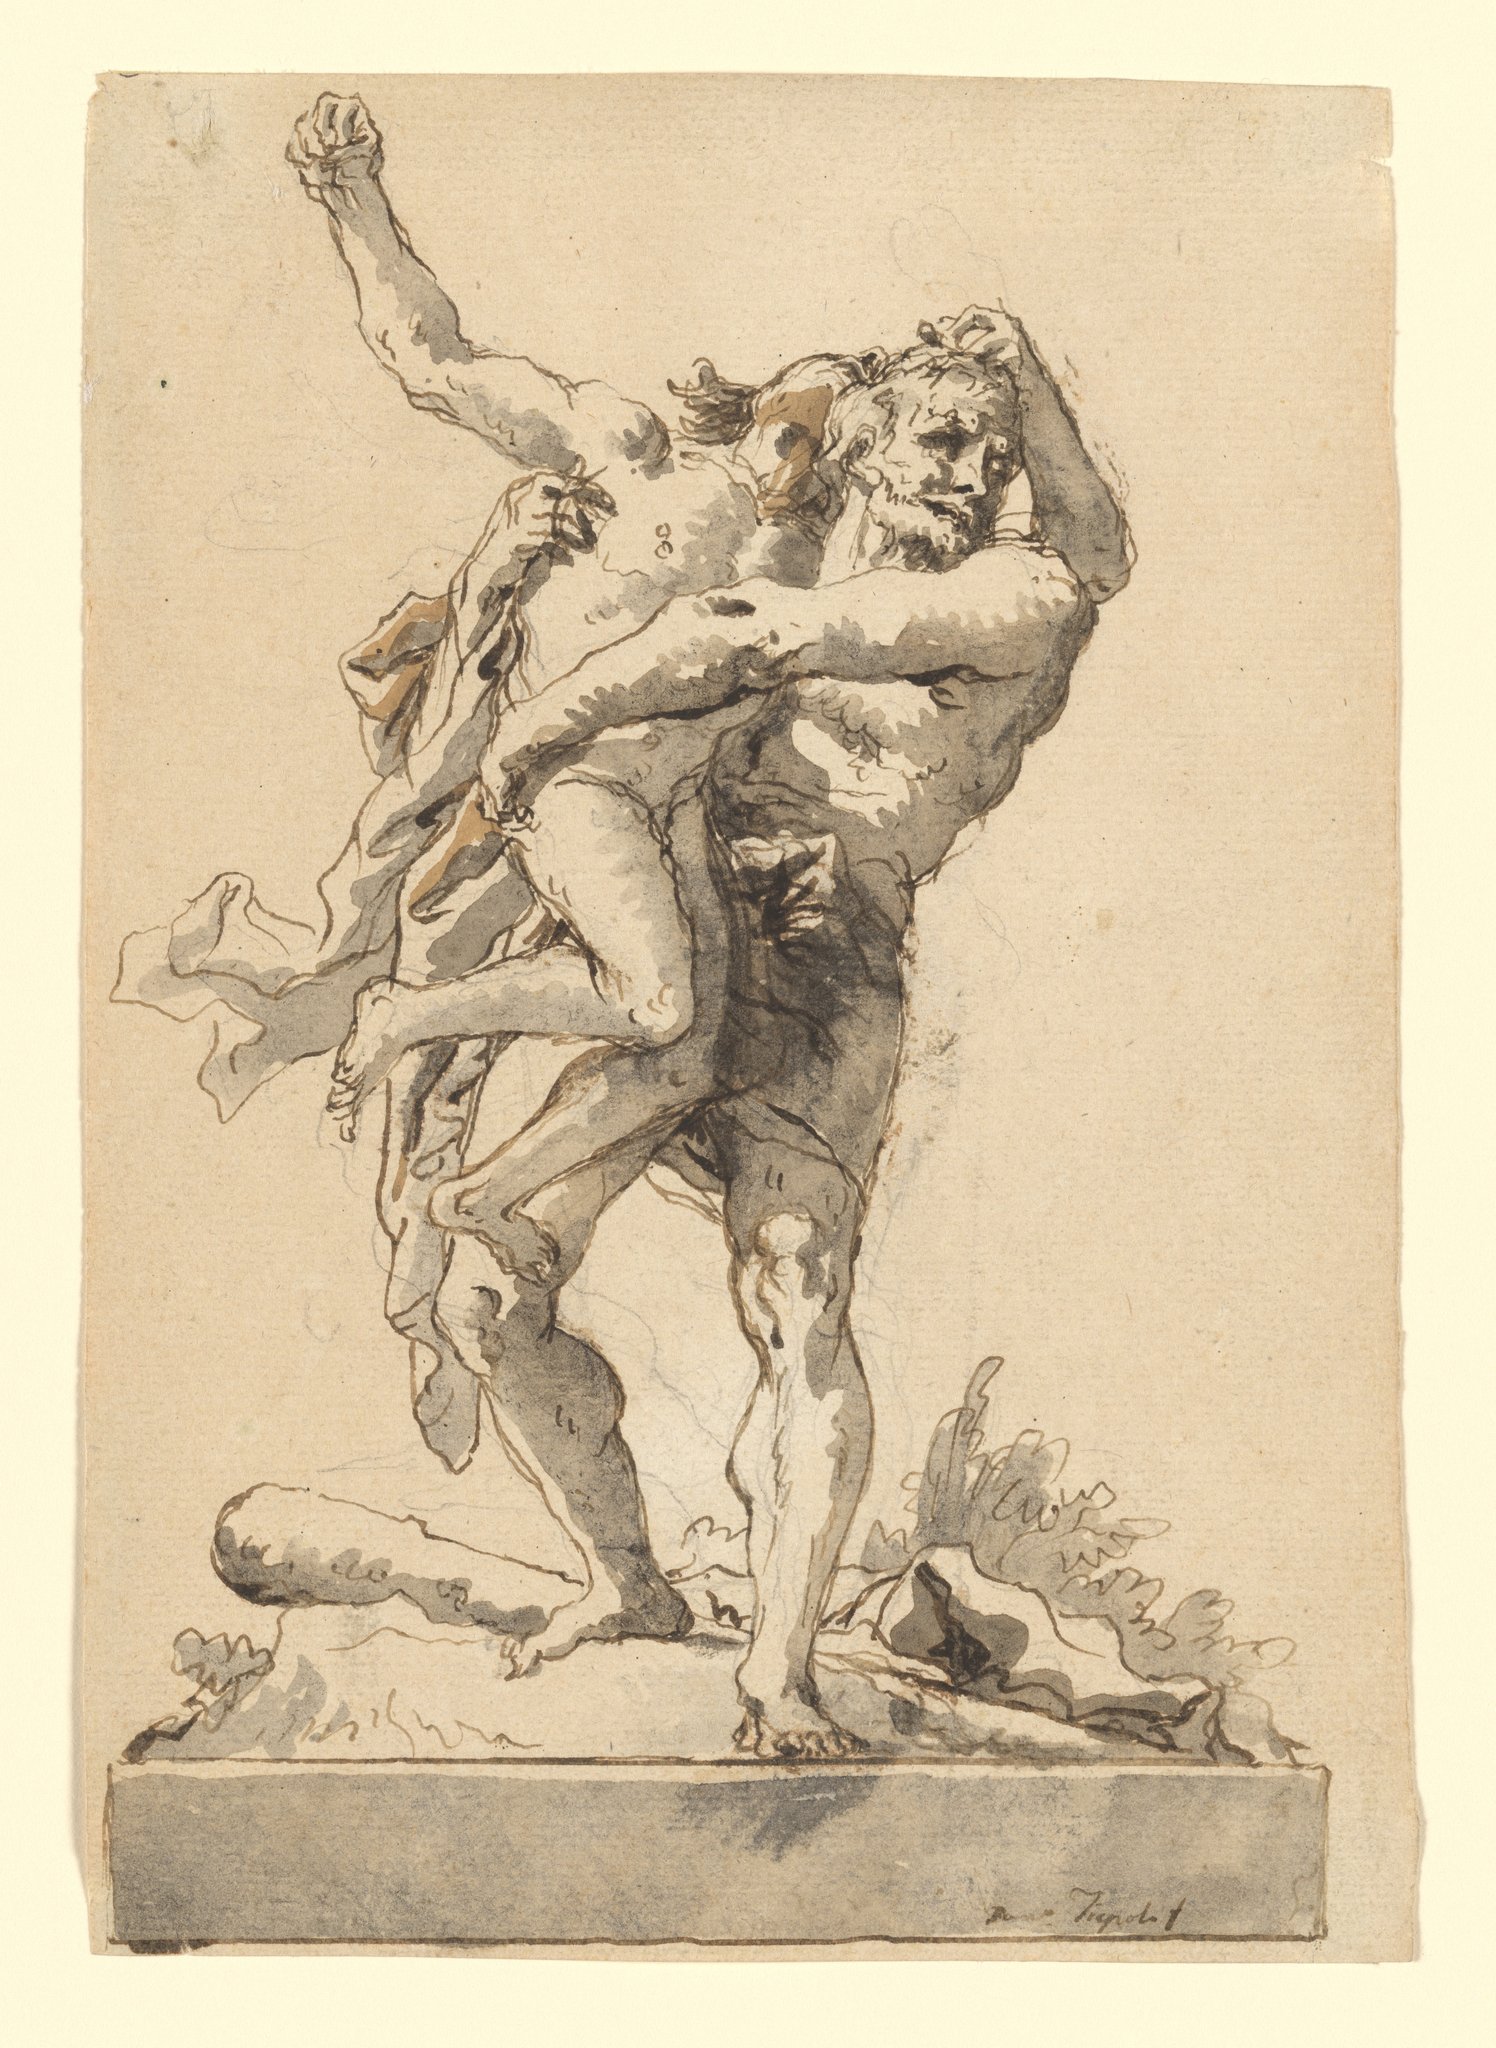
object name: drawing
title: Hercules and Antaeus (with a Base Below)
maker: giovanni domenico tiepolo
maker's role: artist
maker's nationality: italian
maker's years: 1727-1804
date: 1767-1800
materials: chalk, ink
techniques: pen, wash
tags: hercules